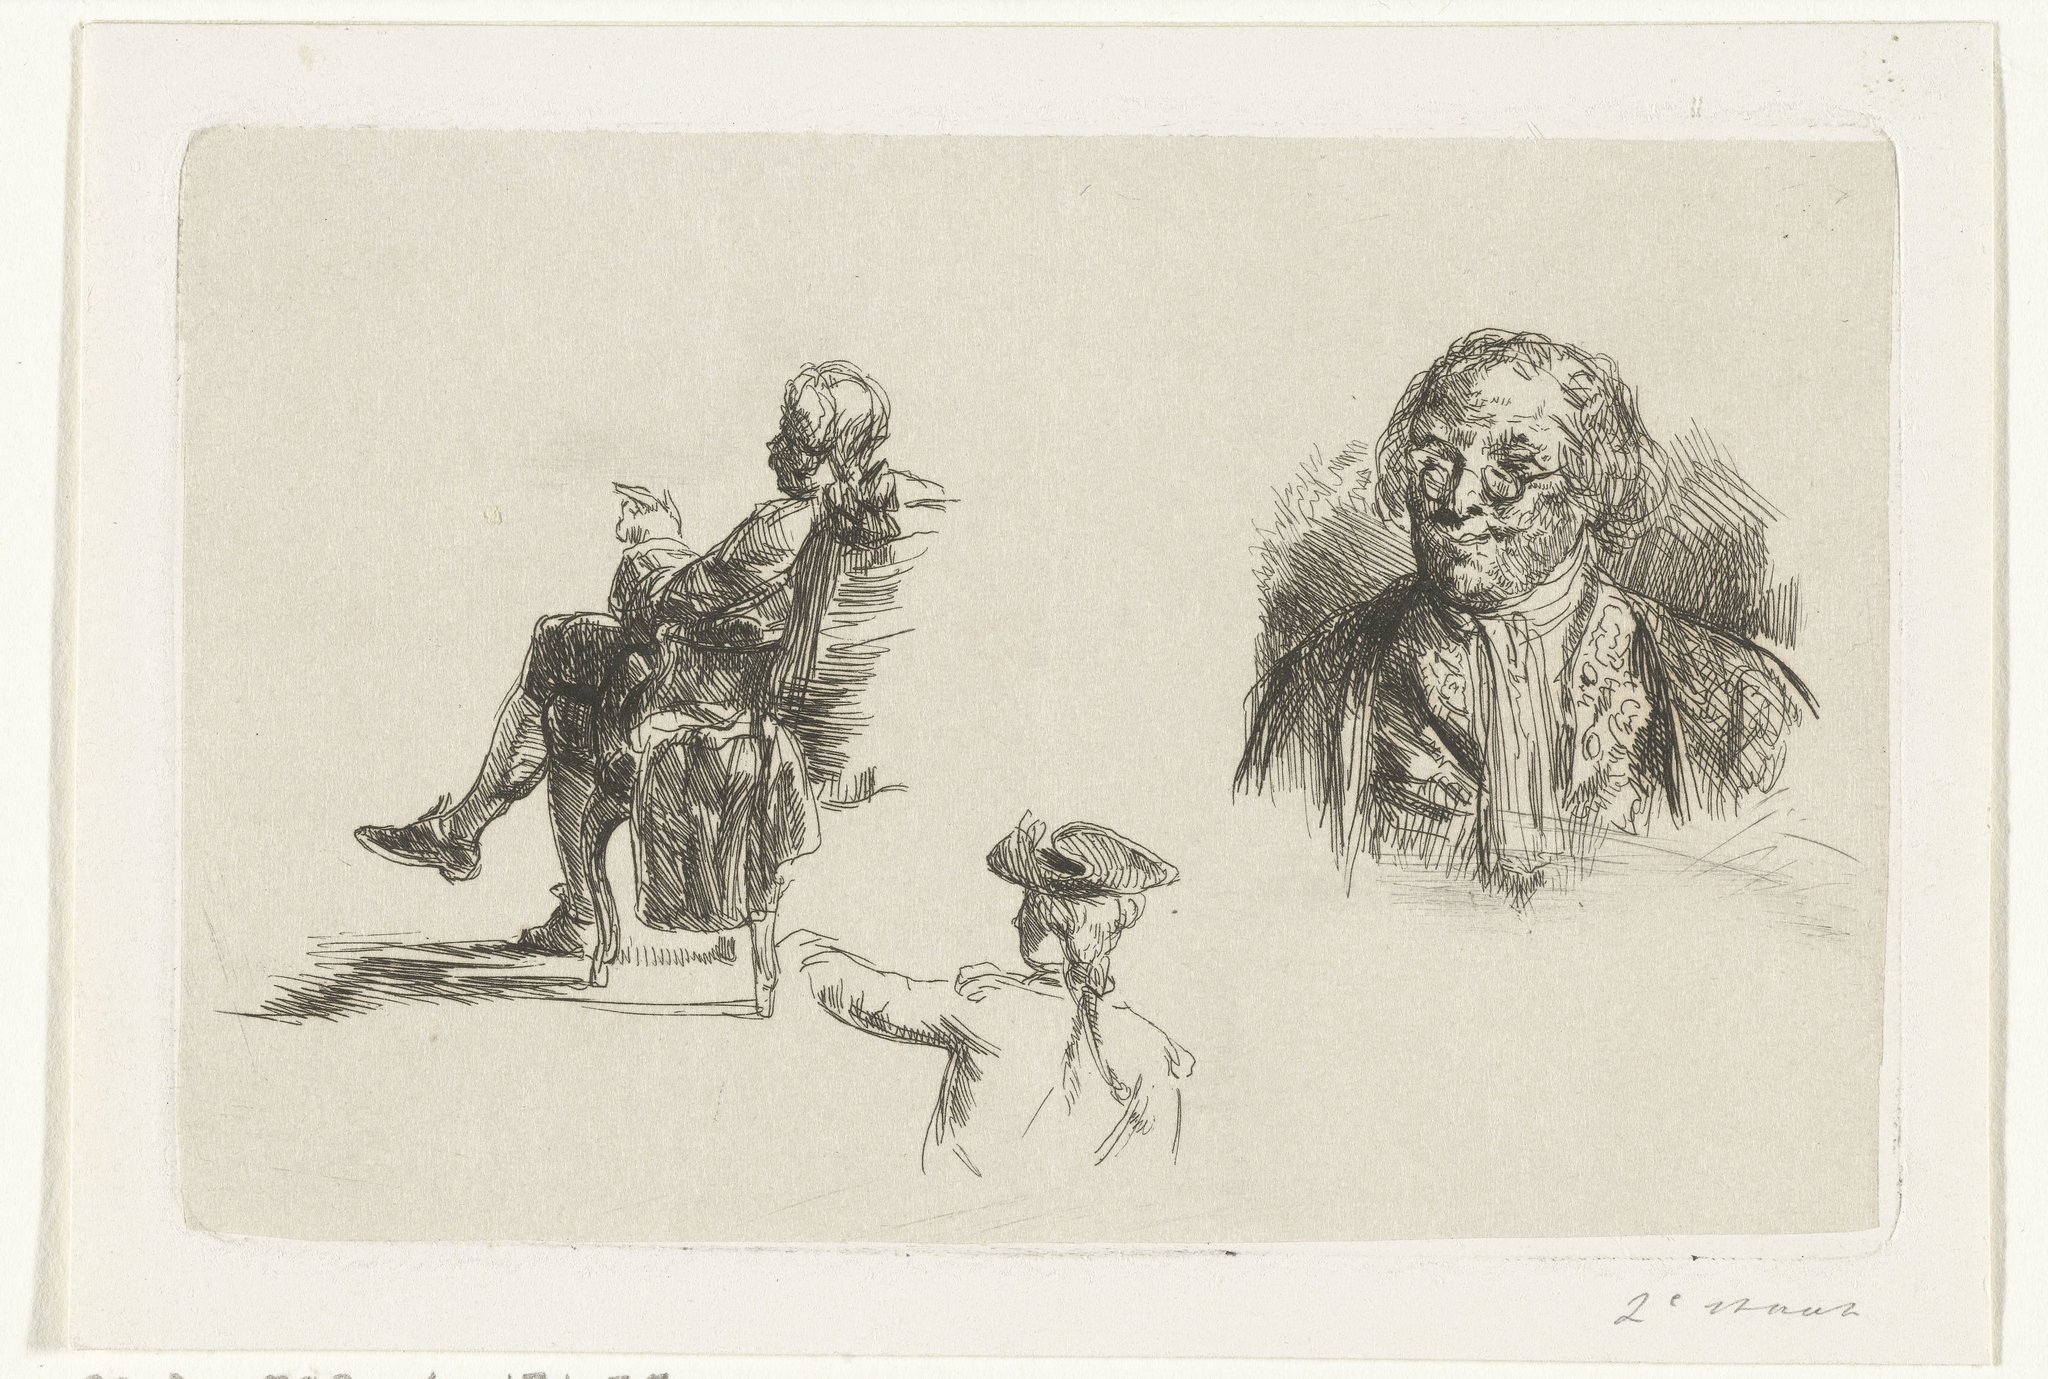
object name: print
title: Studieblad met drie figuren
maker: david bles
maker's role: draughtsman, painter, print maker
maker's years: 1821-1899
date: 1856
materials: paper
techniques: etching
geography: the hague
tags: eyeglasses, spectacles, drawing, sketch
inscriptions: collector's mark: Lugt 2228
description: Links zit een man in een leunstoel, onder een soldaat met een hoed op, rechts een borstbeeld van een oudere heer met bril.